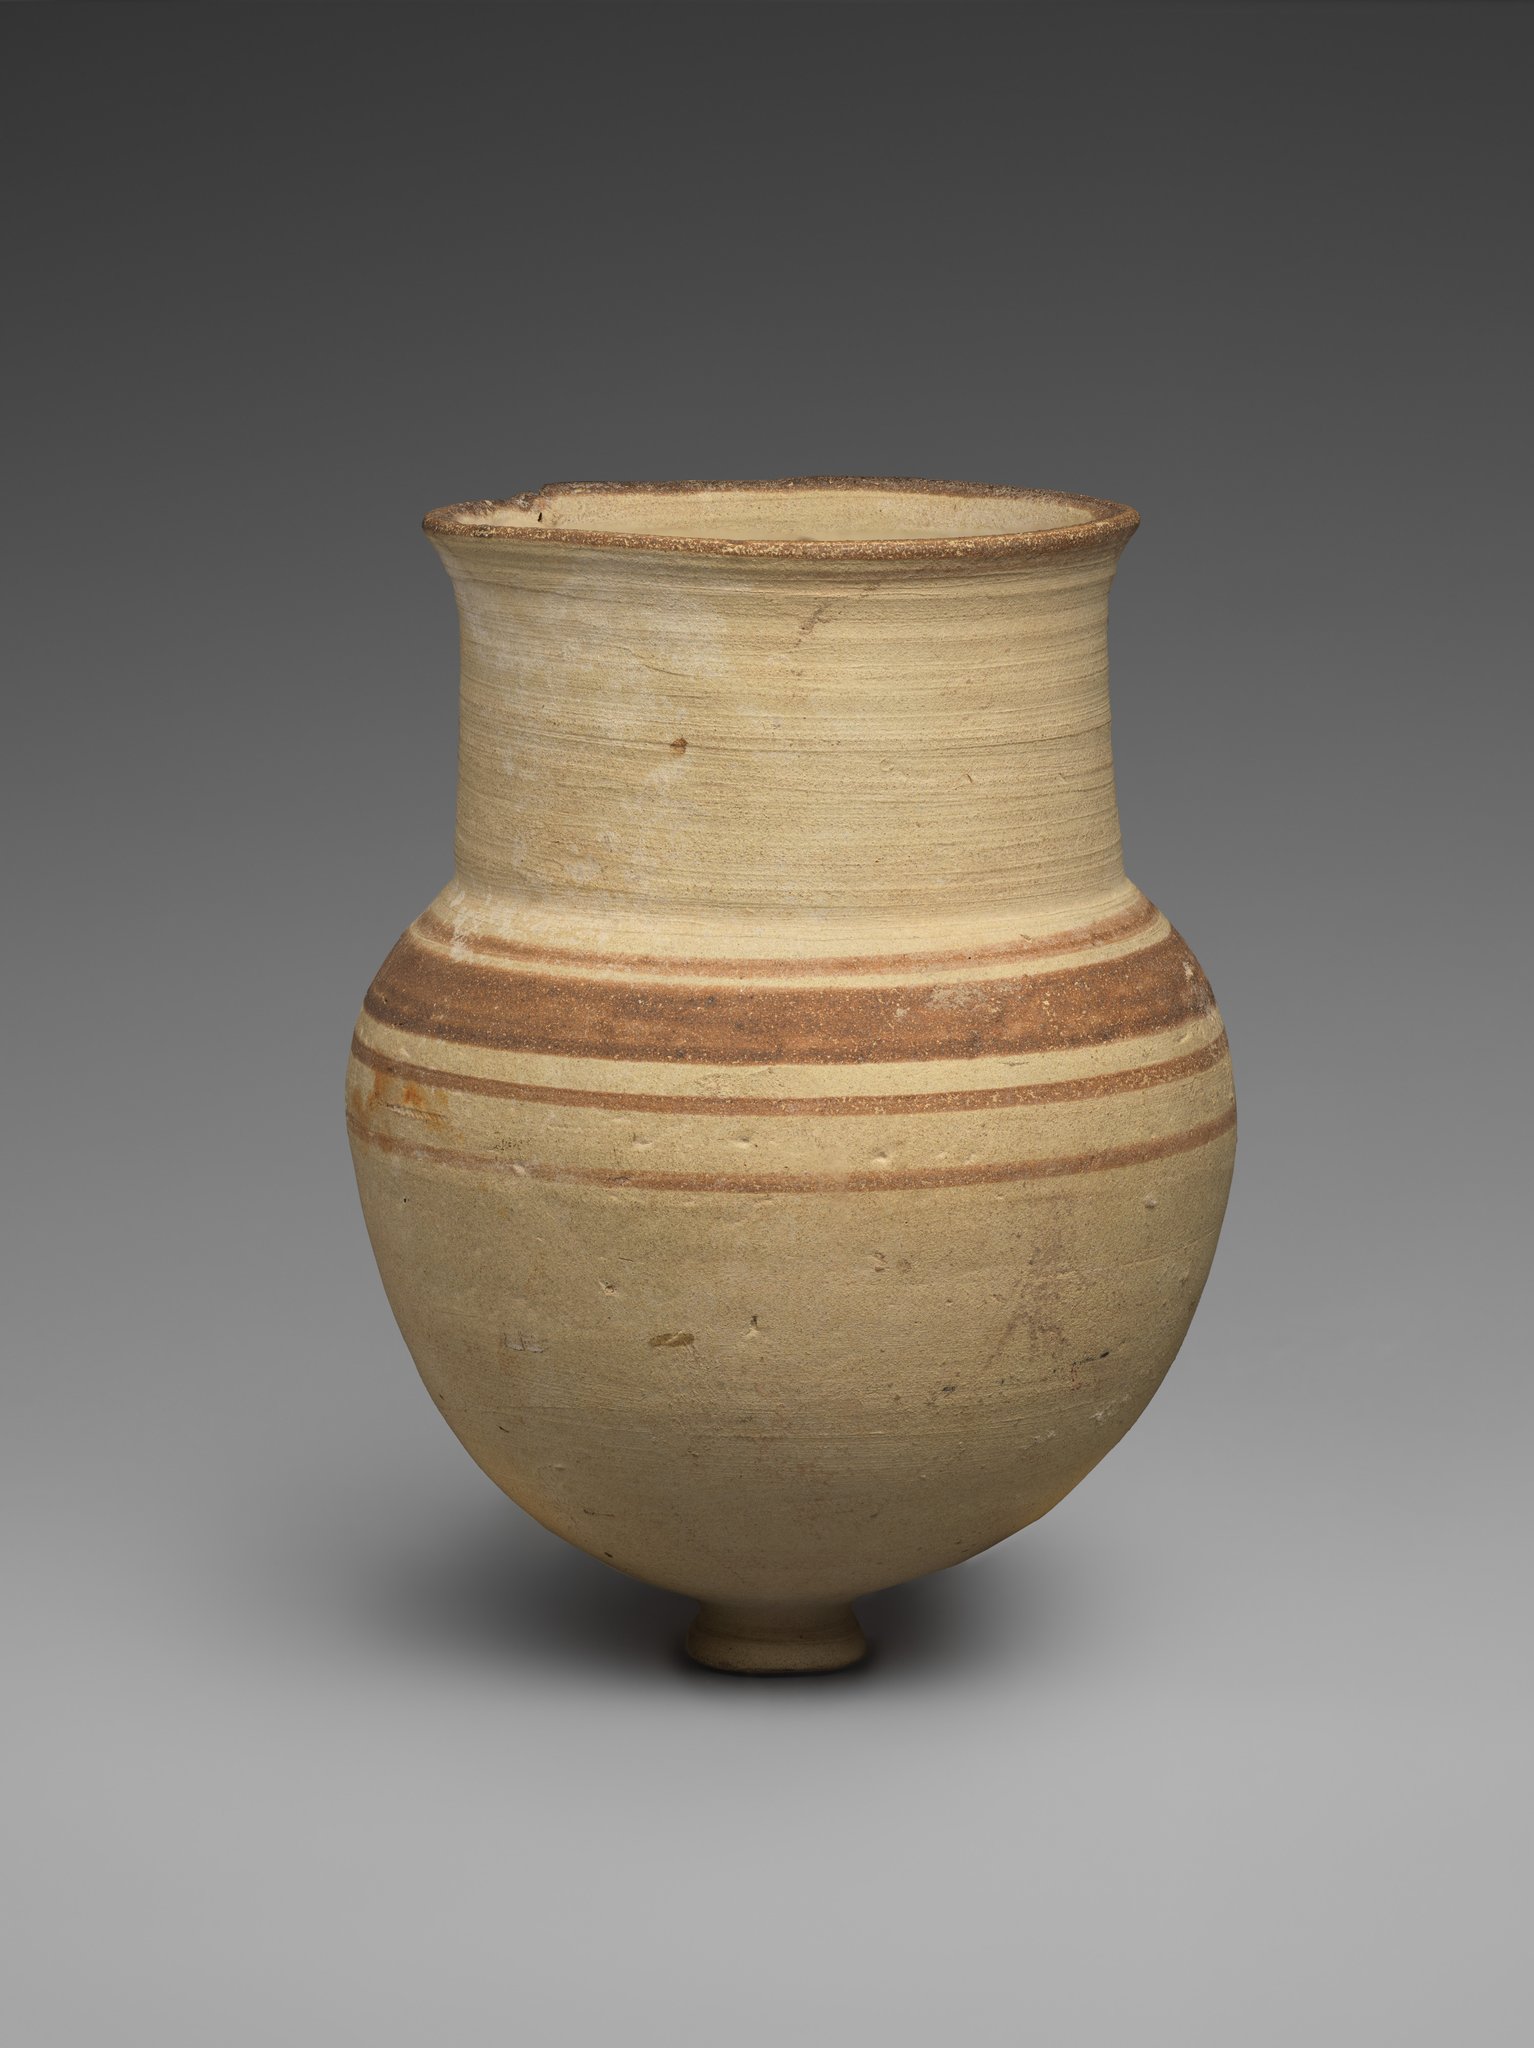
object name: jar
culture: assyrian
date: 1300-1101 BCE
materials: ceramic, paint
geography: mesopotamia